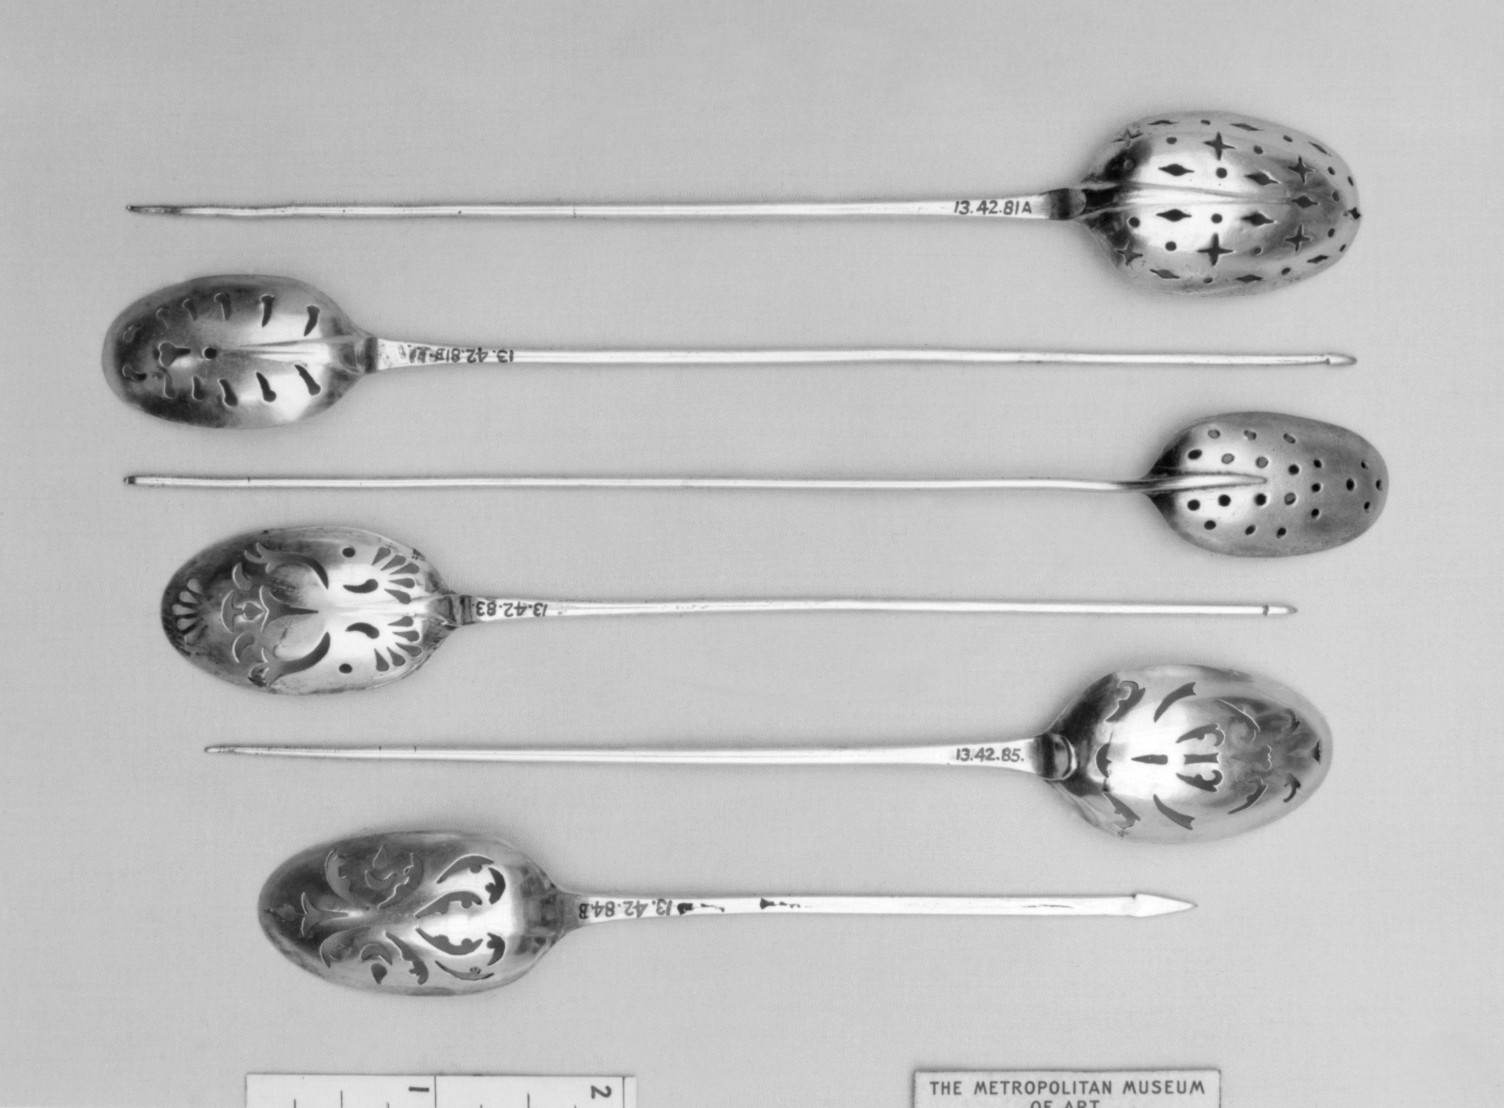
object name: strainer spoon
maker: john perry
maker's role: maker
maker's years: 1757-1779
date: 1701-1800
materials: silver